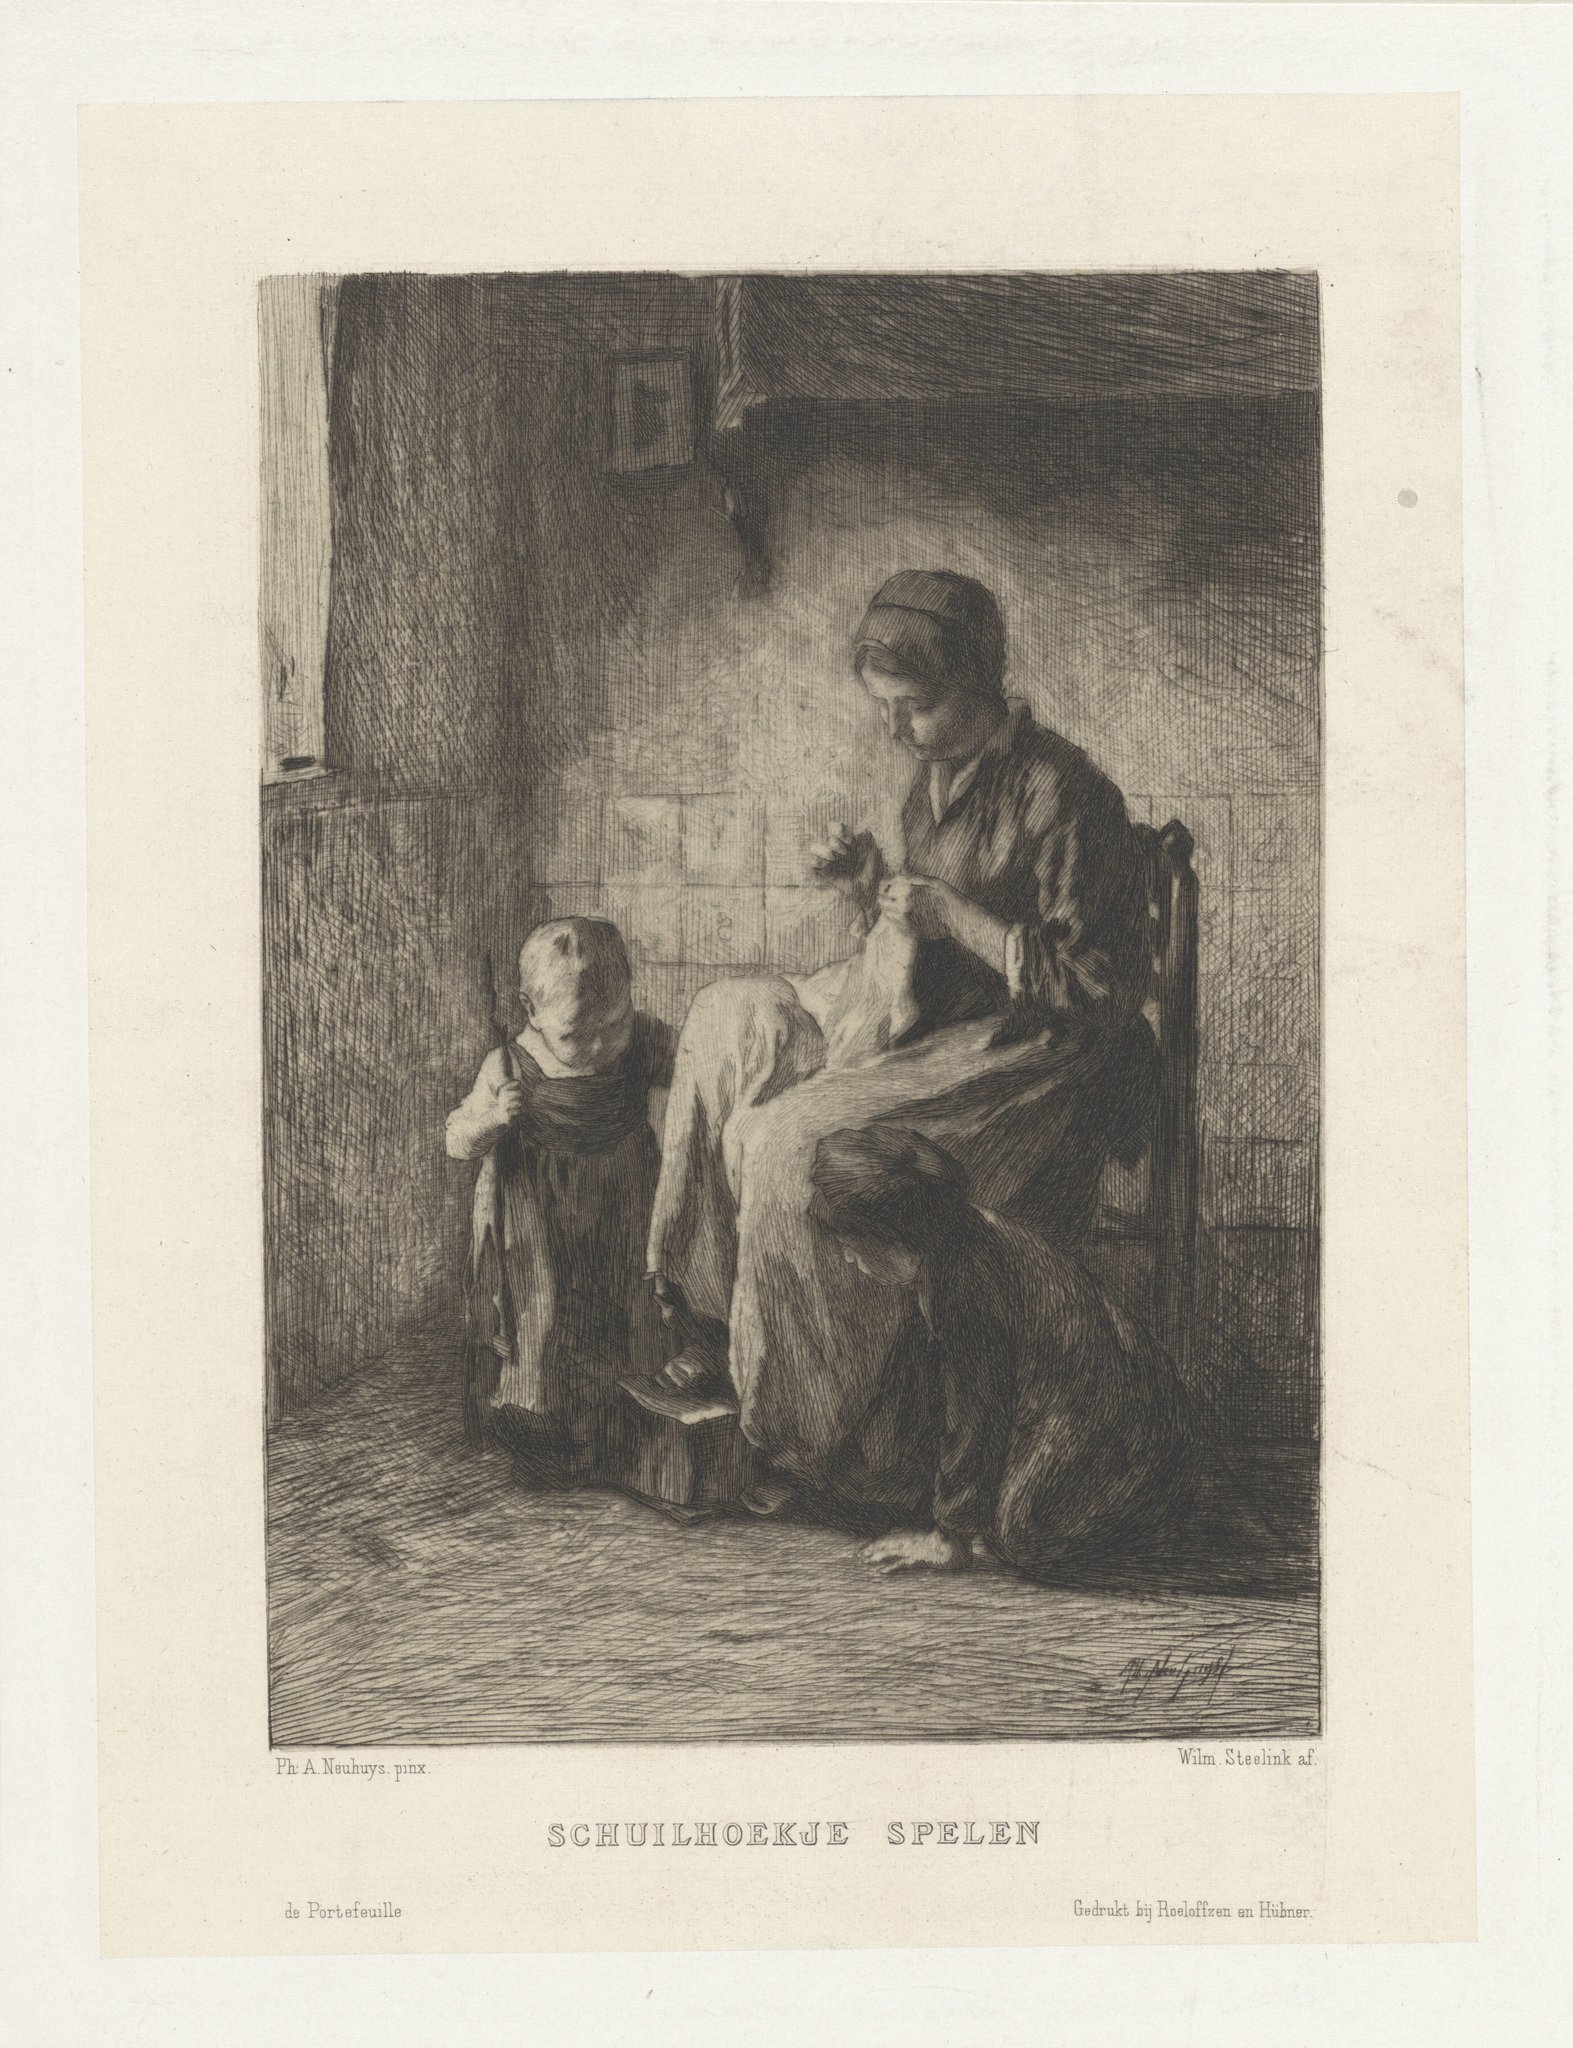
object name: print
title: Verstoppertje spelen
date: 1866-1897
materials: paper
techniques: etching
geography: amsterdam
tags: hide-and-seek, sewing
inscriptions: collector's mark: Lugt 2228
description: Twee kinderen spelen verstoppertje. Hun moeder zit op een stoel tussen hen en is bezig met handwerken.